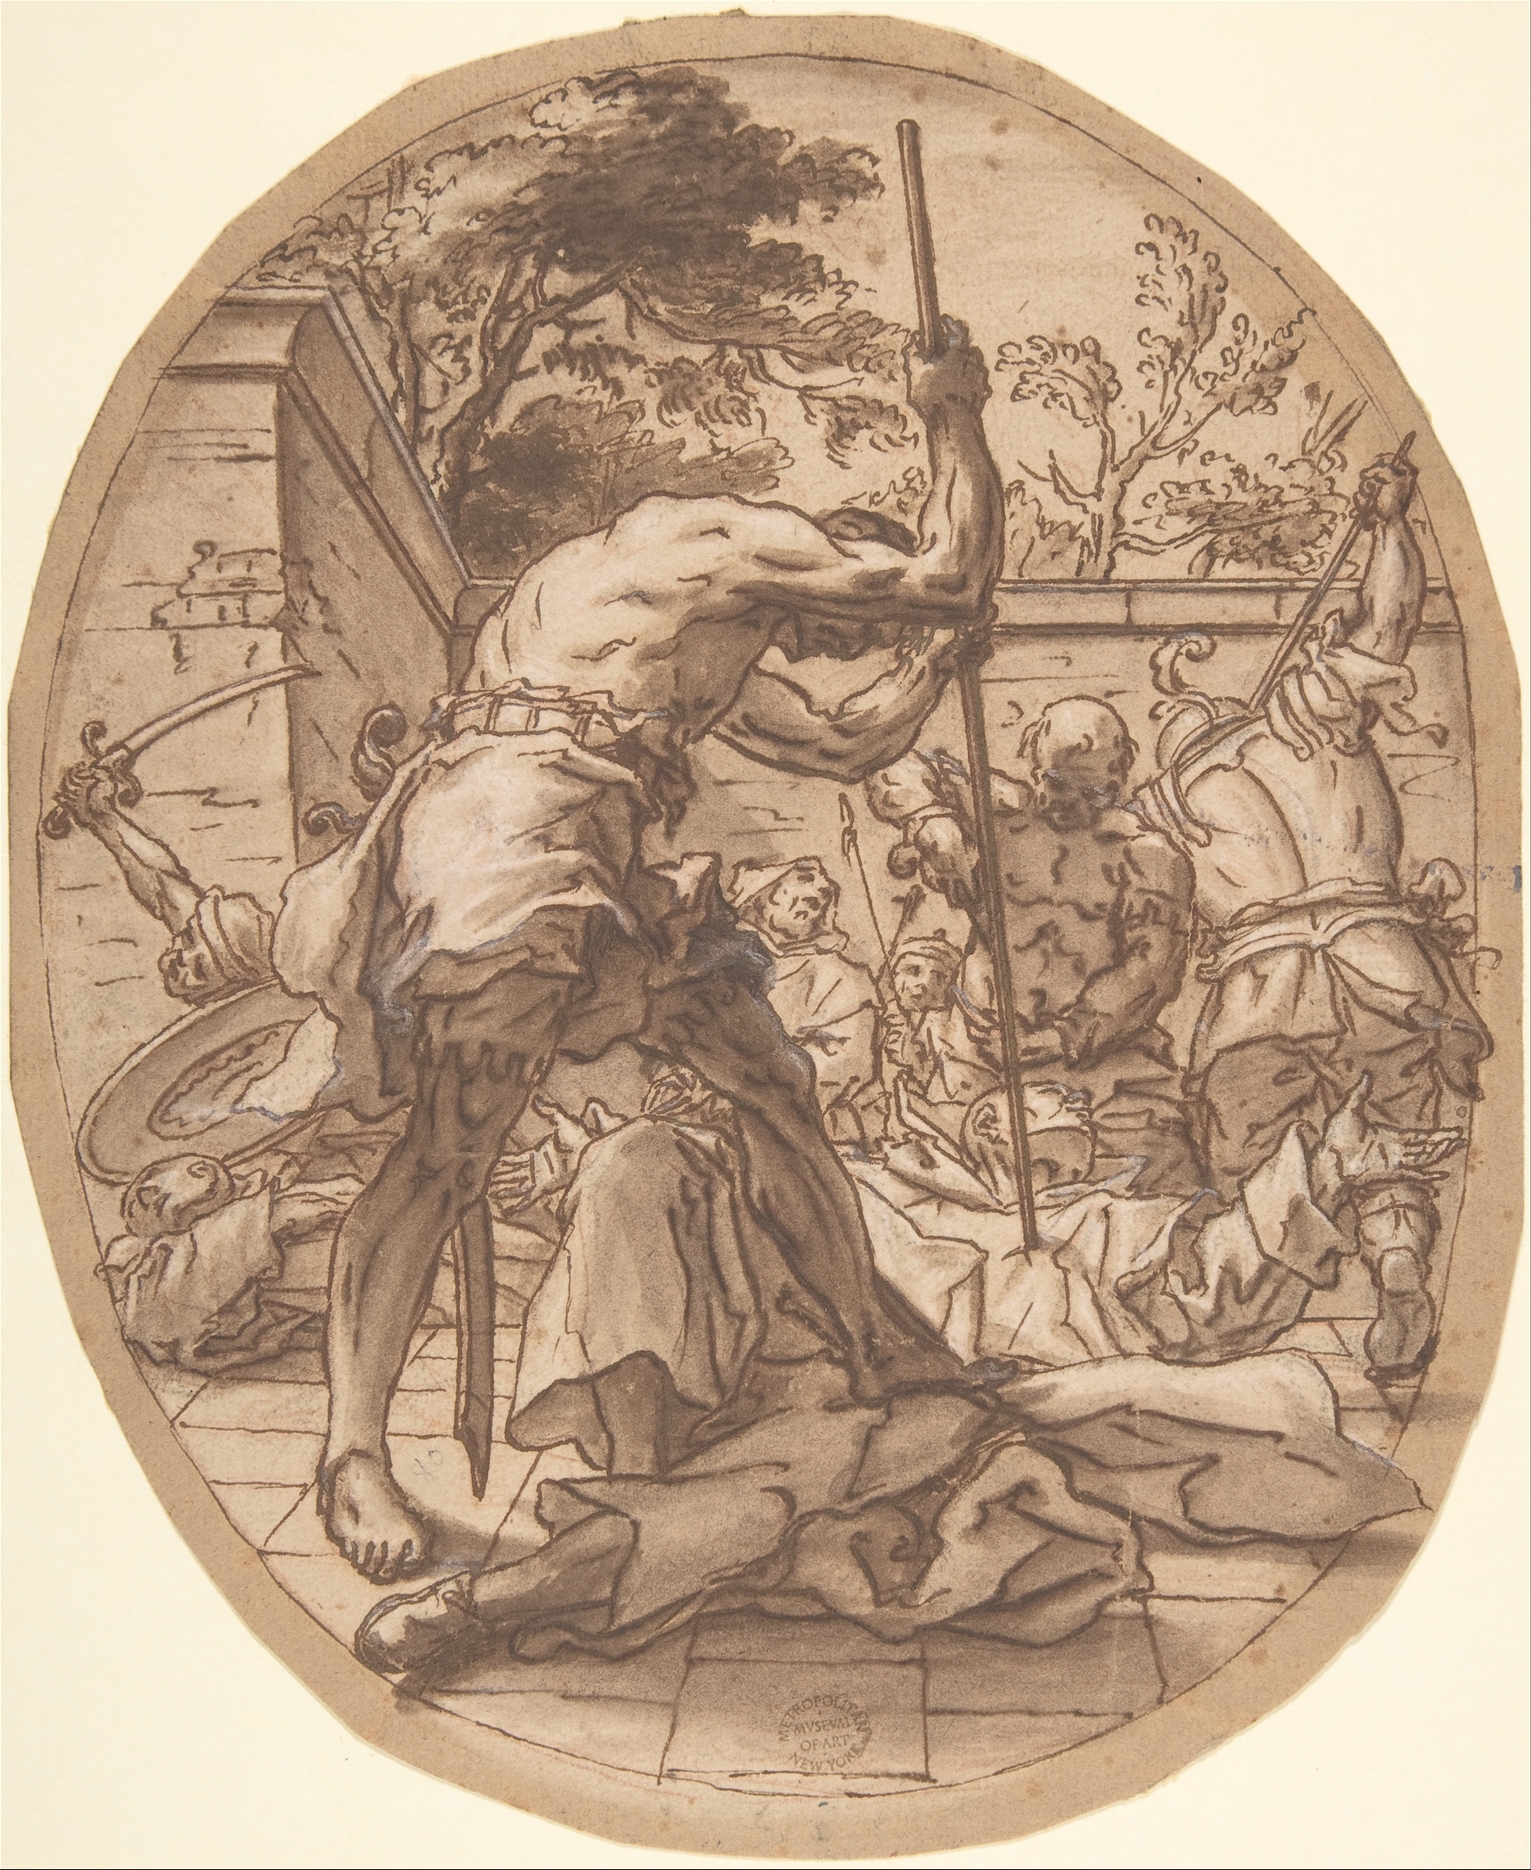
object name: drawing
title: A Massacre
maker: anonymous, italian, roman-bolognese, 17th century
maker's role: artist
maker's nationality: italian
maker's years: 1600-1700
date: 1601-1700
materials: chalk, gouache, ink, paper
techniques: brush, pen, wash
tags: massacres,swords,men,trees